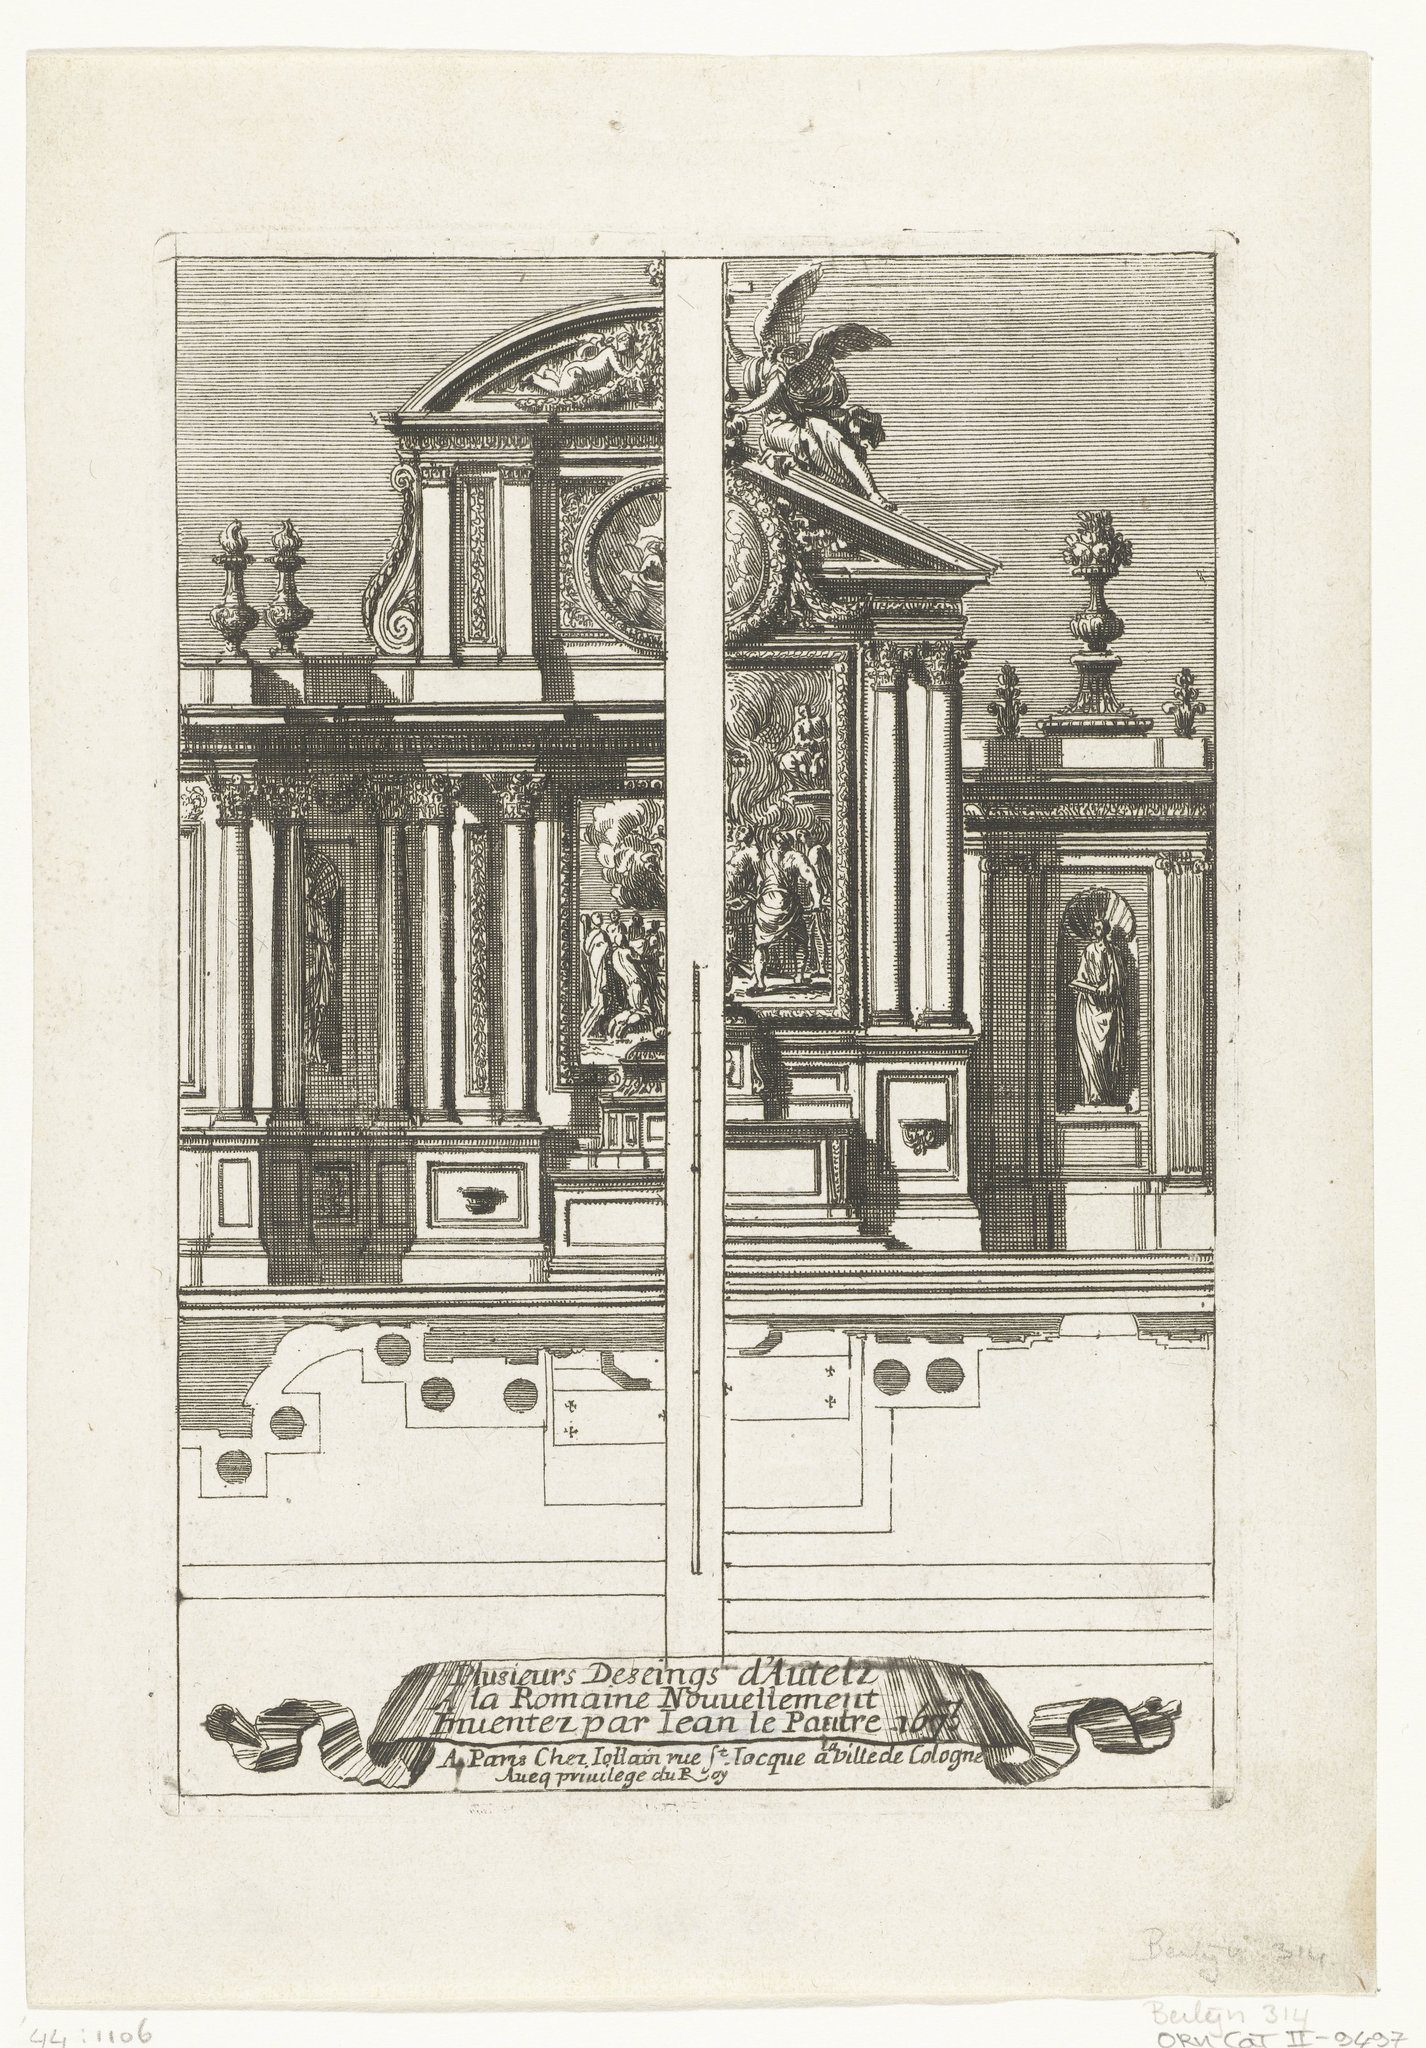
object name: print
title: Plusieurs Deseings d'Autelz A la Romaine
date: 1673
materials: paper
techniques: etching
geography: paris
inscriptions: date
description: Linkervariant met gekoppelde, vrijstaande Korintische zuilen. Uit serie van 6 bladen, tweede editie.